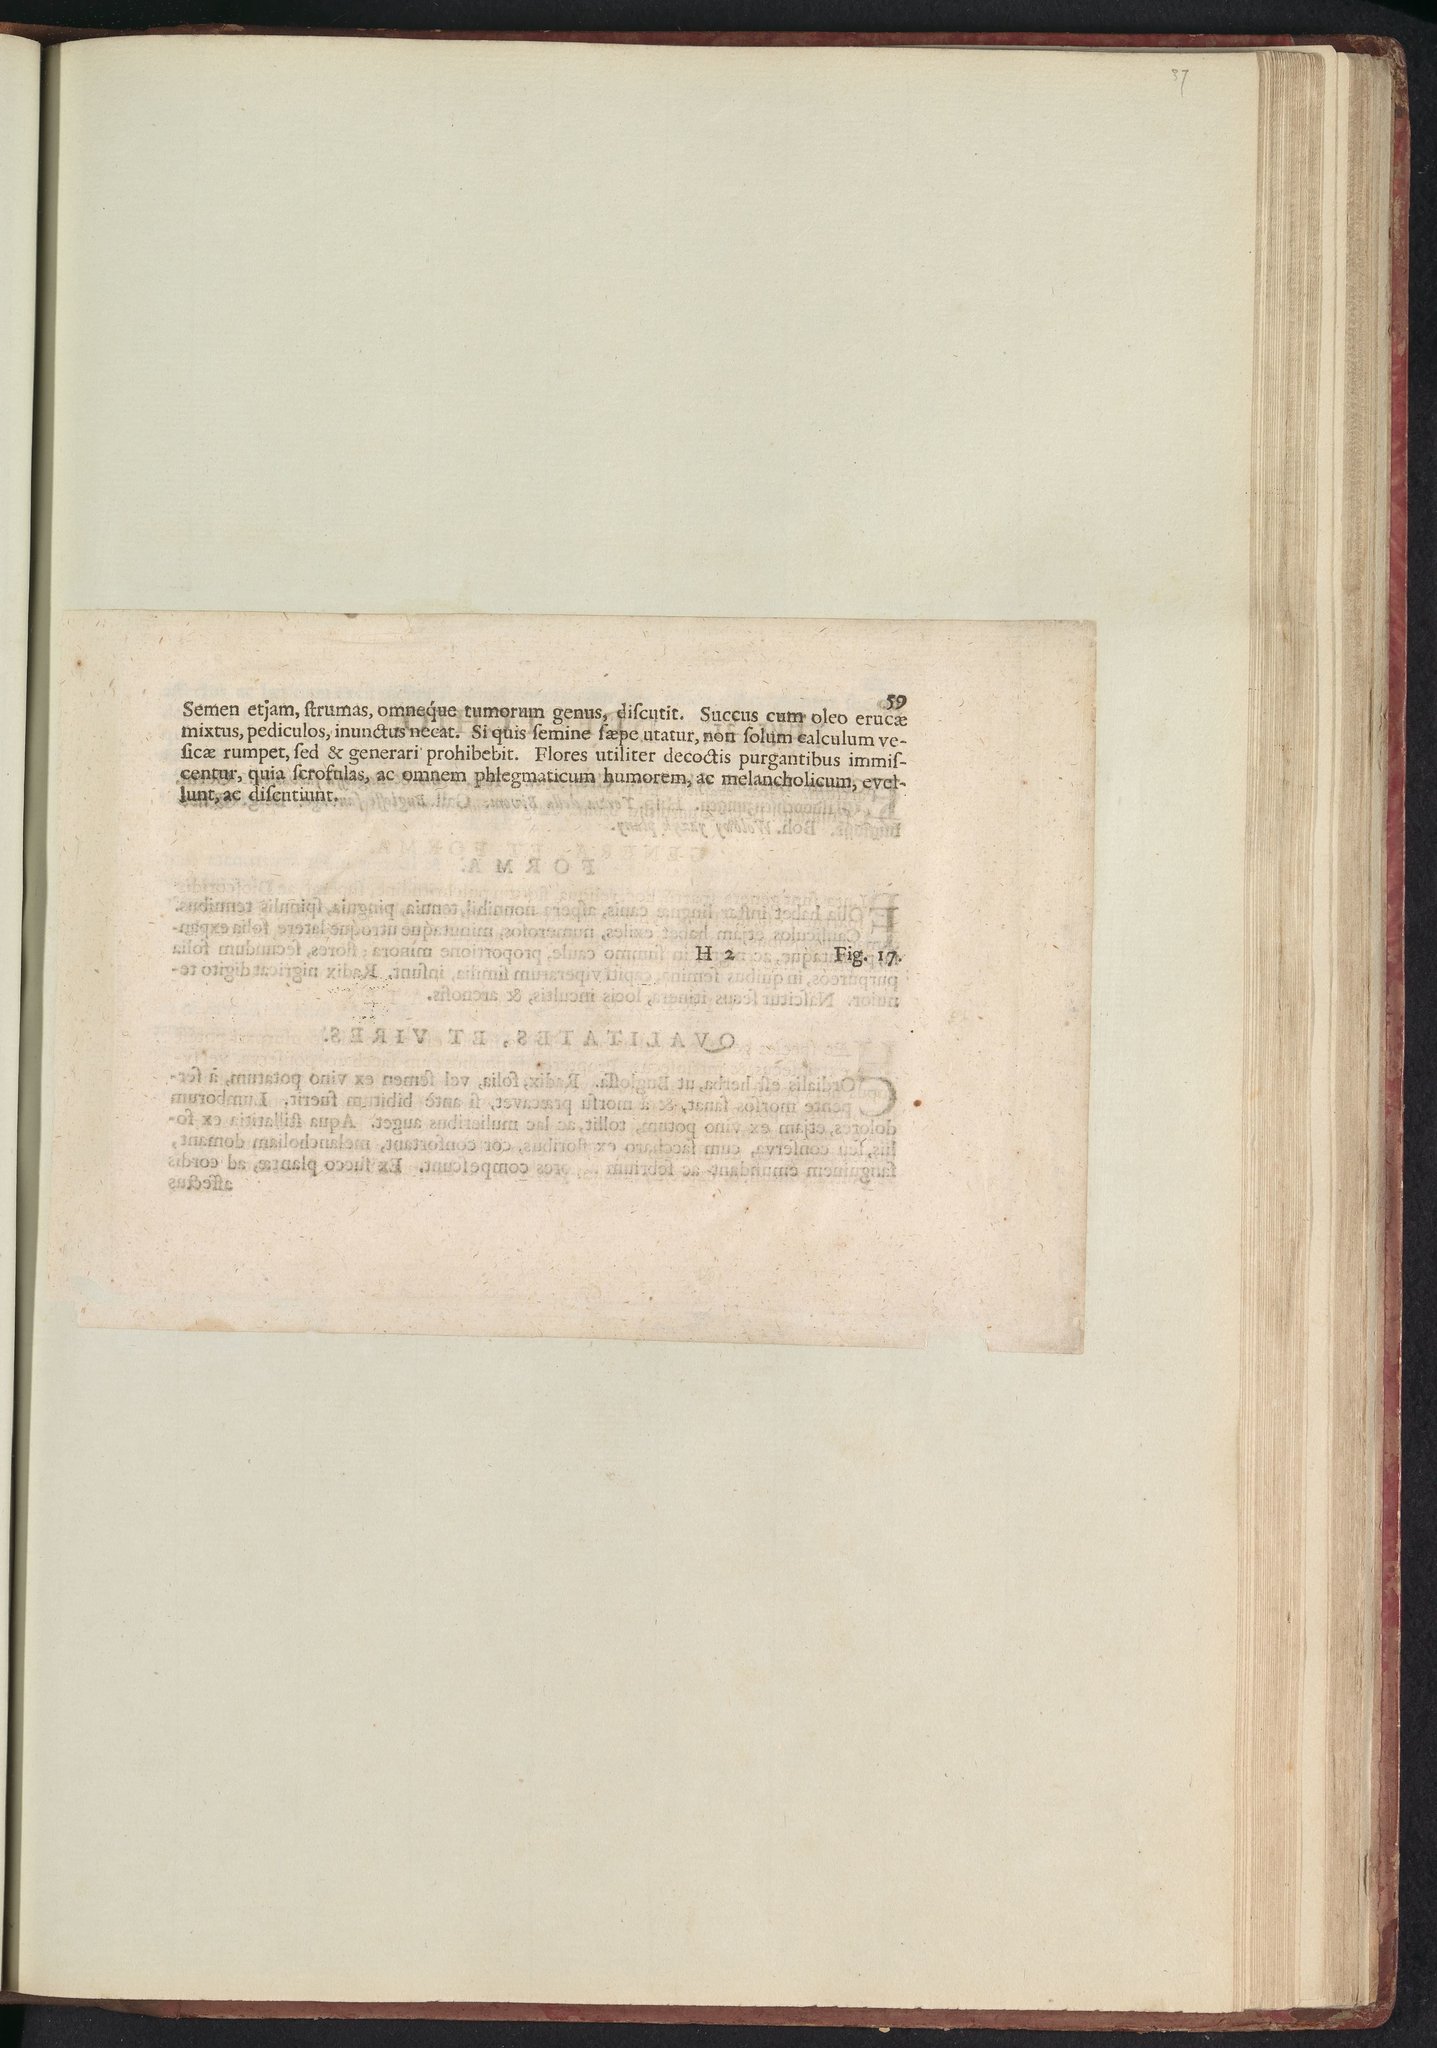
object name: text sheet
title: Fig. 30 'De Spartio' in De Boodts herbarium van 1640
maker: anselmus boëtius de boodt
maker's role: draughtsman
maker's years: 1550-1632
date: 1640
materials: ink, paper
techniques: letterpress printing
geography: bruges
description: Beschrijving bij Fig. 30 op p. 59 in: Anselmi Boëtii de Boot I.C. Brugensis & Rodolphi II. Imp. Roman. medici a cubiculis Florum, Herbarum, ac fructuum selectiorum icones, & vires pleraeque hactenus ignotæ. Onderdeel van het album met bladen en platen uit De Boodts herbarium van 1640. Het twaalfde van twaalf albums met aquarellen van dieren, vogels en planten bekend rond 1600, gemaakt in opdracht van keizer Rudolf II.